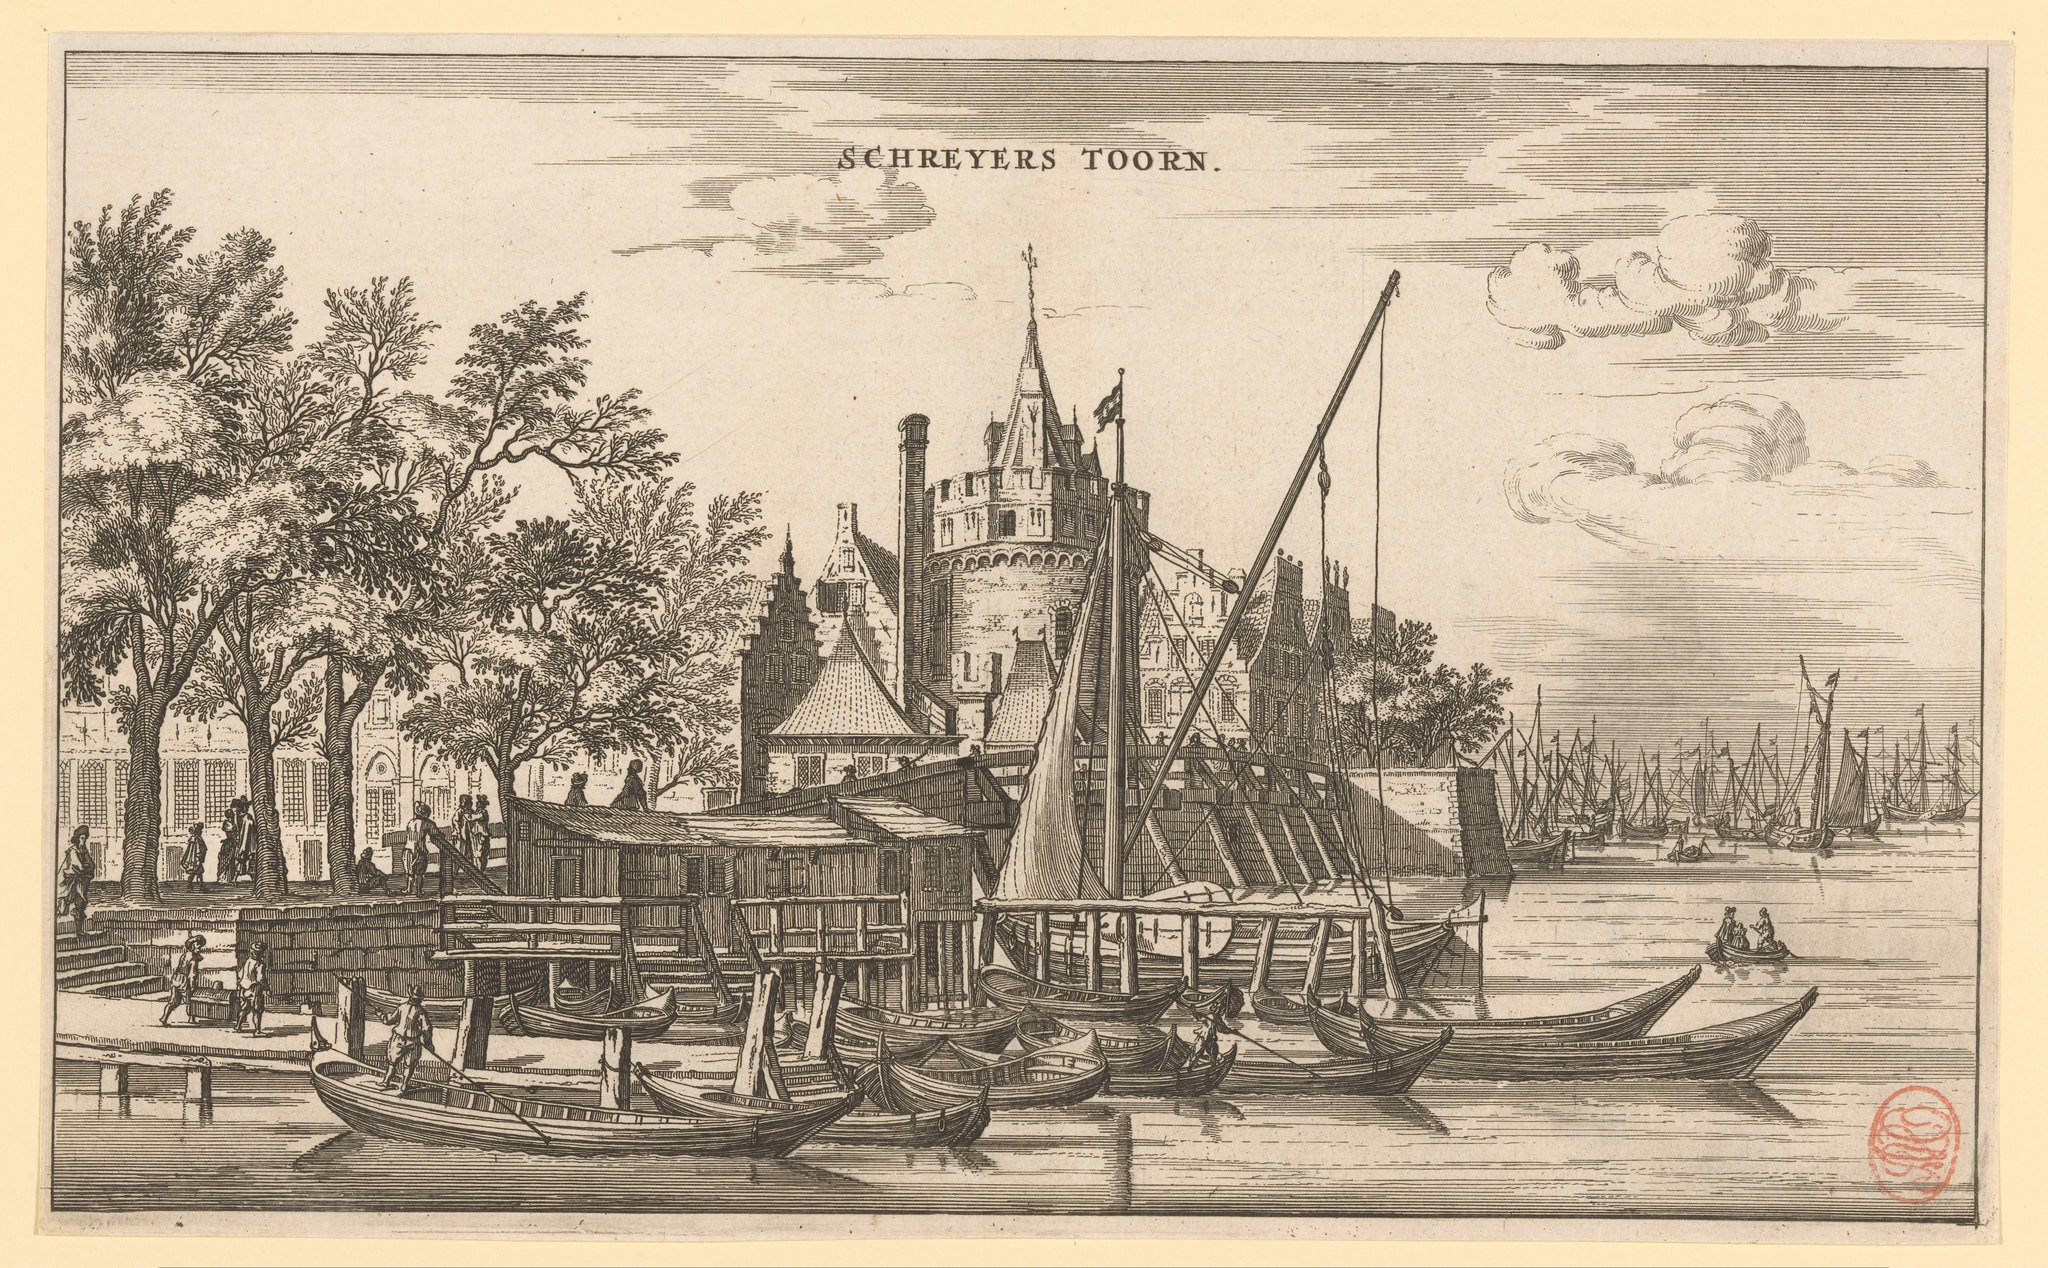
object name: book illustration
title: Schreyers Toorn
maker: jacob van meurs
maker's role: draughtsman, print maker, publisher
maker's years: 1619-1680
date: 1663-1664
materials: paper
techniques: engraving, etching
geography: amsterdam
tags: bridge in city across river, canal, etc. (+ city(-scape) with figures, staffage), towers ~ fortified city, canals, waters (in city) (+ city(-scape) with figures, staffage), street (+ city(-scape) with figures, staffage)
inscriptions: collector's mark: Lugt 195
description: Huidige staat van prent ook gebruikt in: Dapper, Olfert. Historische beschryving der stadt Amsterdam: waer in de voornaemste geschiedenissen (na een kort verhael van gansch Hollant en d'omleggende dorpen (…). Amsterdam: Jacob van Meurs, 1663.* En in: Zesen, Philipp von. Beschreibung der Stadt Amsterdam: darinnen von derselben ersten Ursprunge bis auf gegenwärtigen Zustand (…). Amsterdam: Joachim Nosche, 1664. * In sommige exemplaren van deze uitgave komt de huidige staat van de prent voor. In andere exemplaren is een latere staat ingebonden, waarop boven de Nederlandse een Franse titel is toegevoegd.